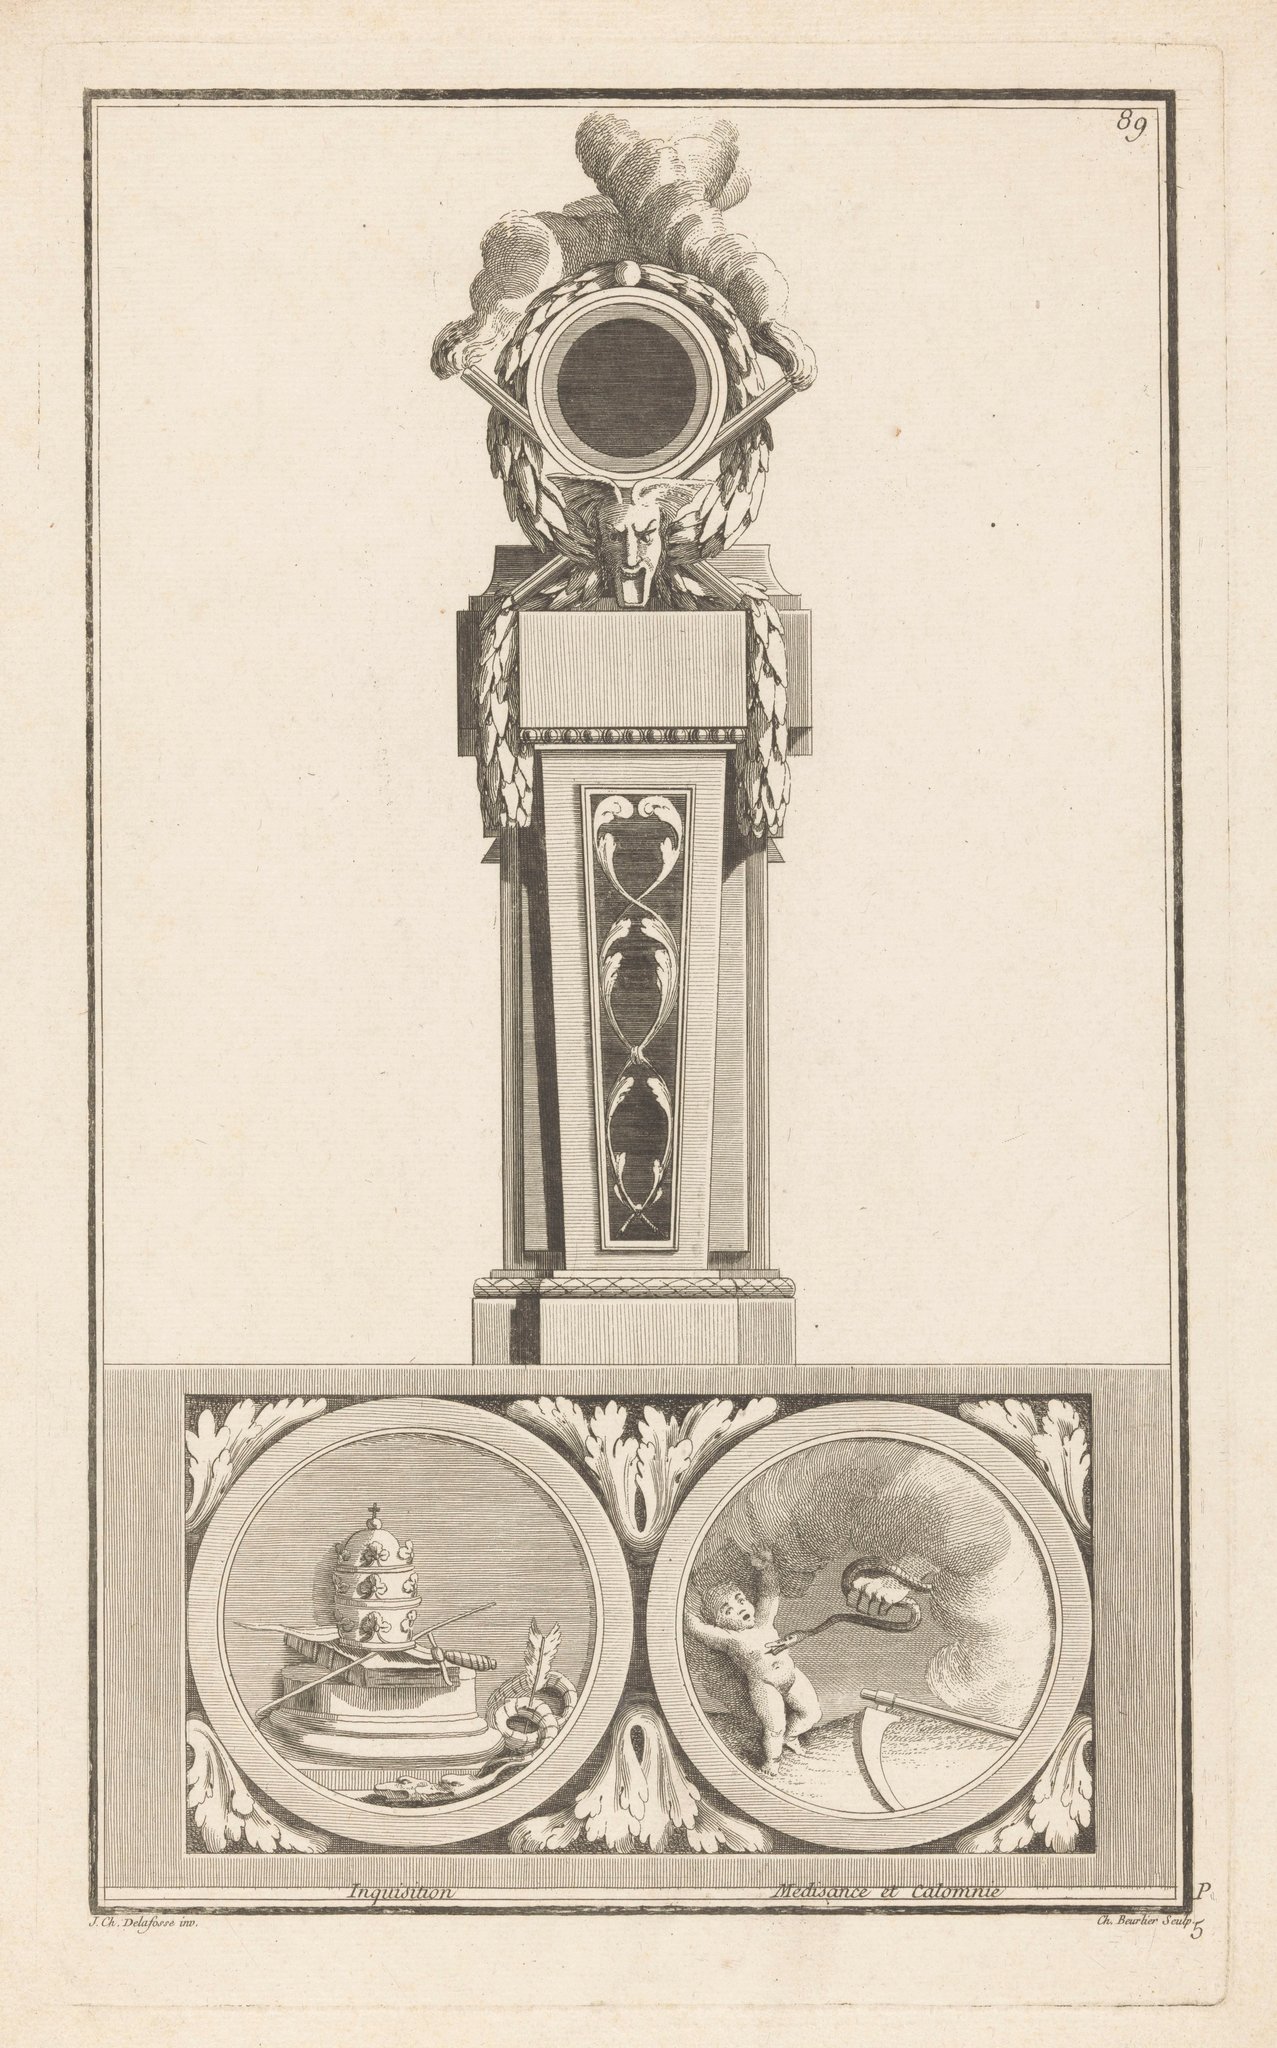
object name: print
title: P Pendules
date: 1768-1771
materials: paper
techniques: engraving, etching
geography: paris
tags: slander, calumny, detraction; 'biasimo vitioso', 'calunnia', 'detrattione', 'maledicenza' (ripa), clock, inquisition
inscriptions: collector's mark: Lugt 2760, collector's mark: Lugt 2228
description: Een geornamenteerde pendule met guirlandes, een gevleugeld masker en fakkels. Daaronder twee ronde medaillons, links met de pauselijke tiara met een boek op een basement en slangen en rechts met een zeis, een hand met een slang en een bange putto. Prentnummer 89.